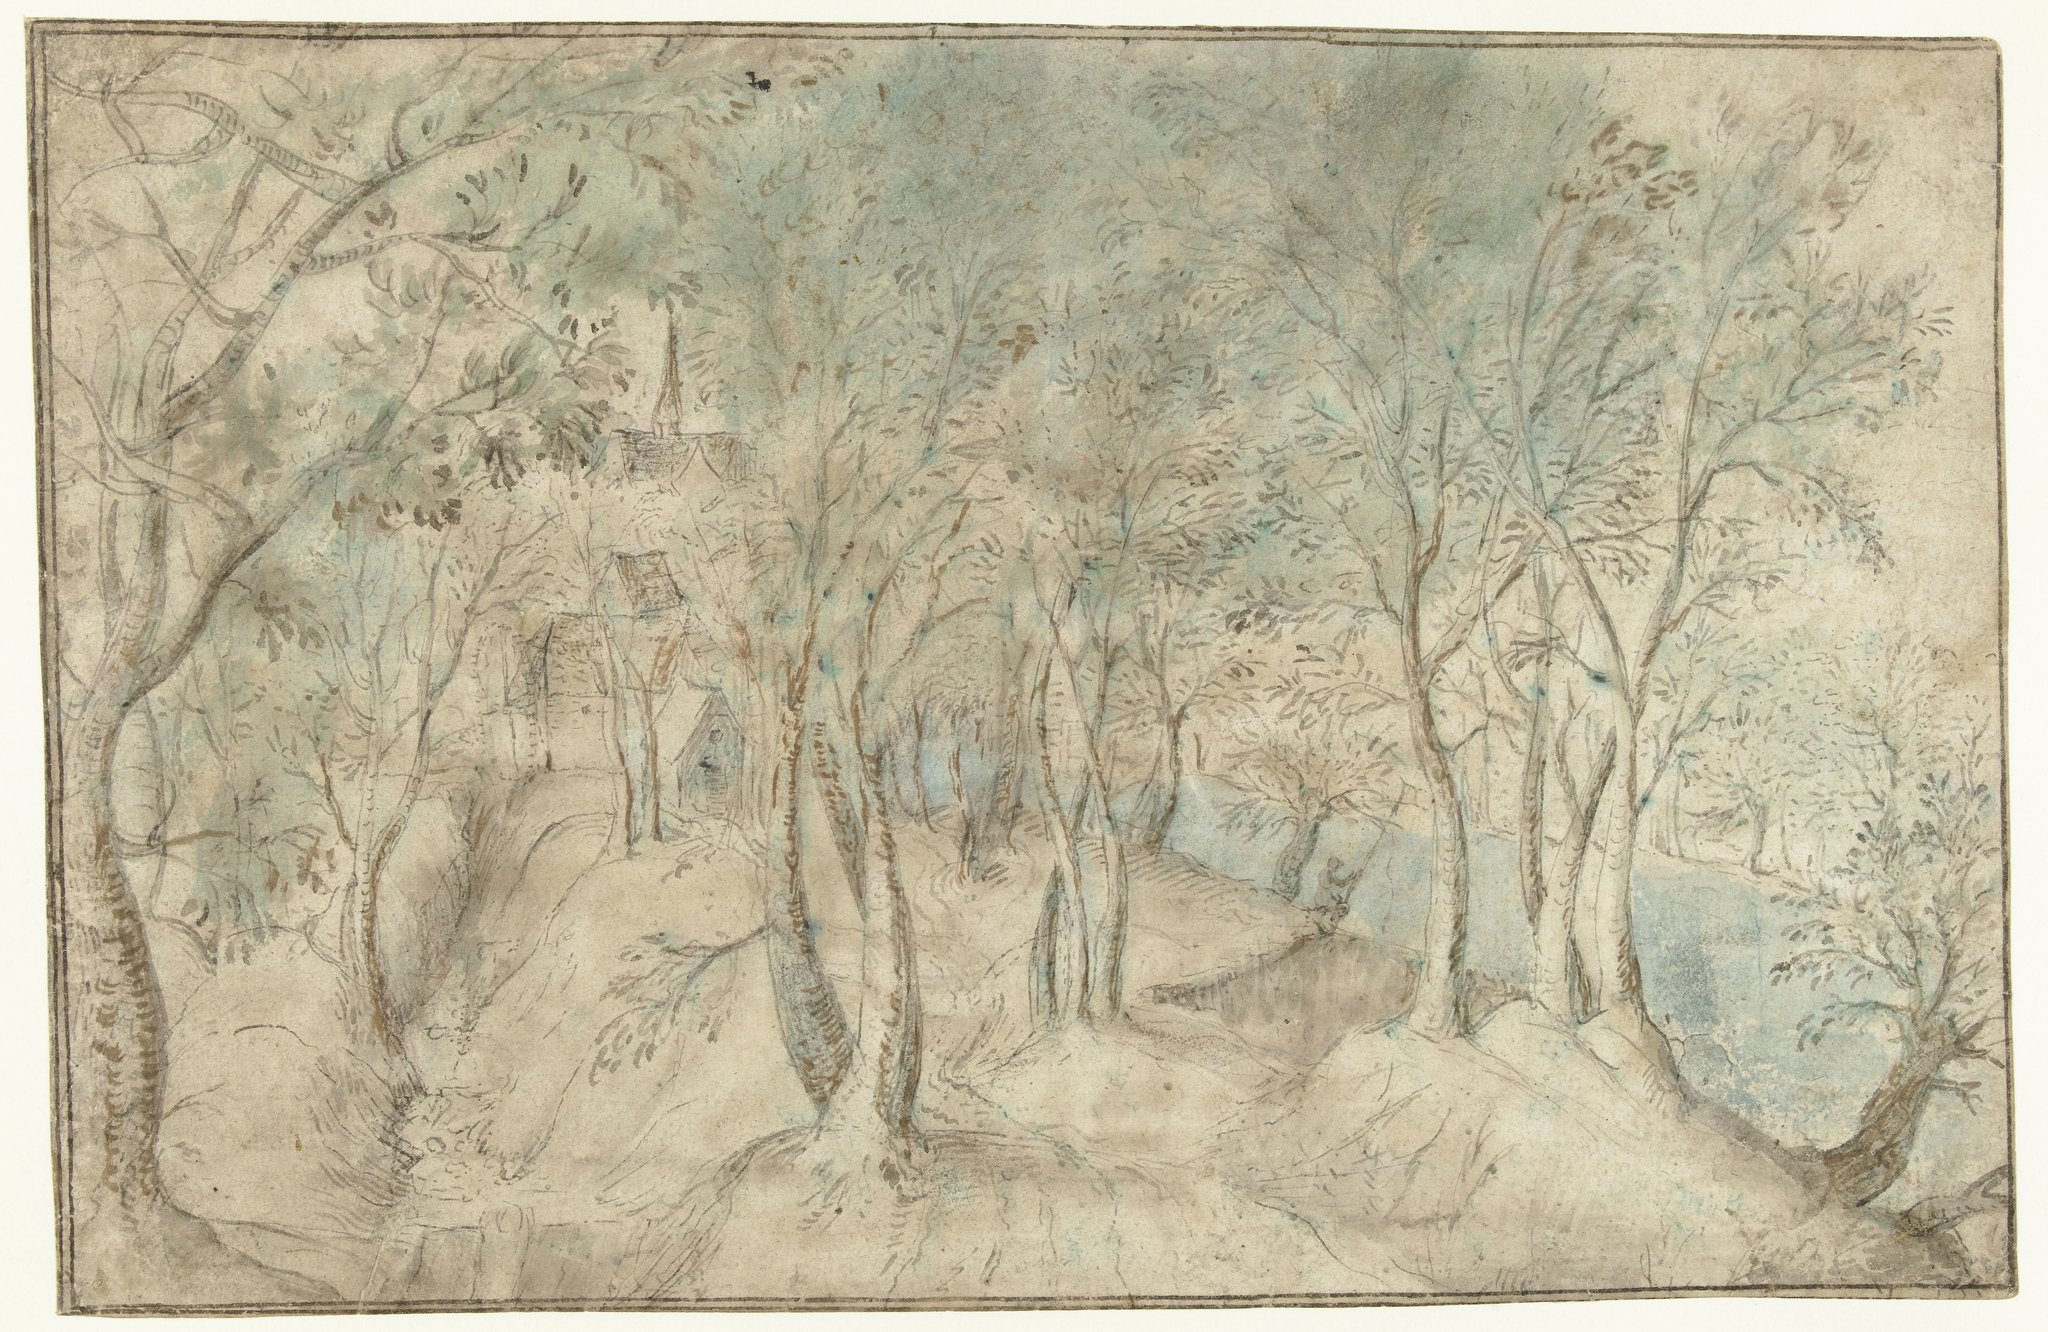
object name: drawing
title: Gezicht op een dorp bij een rivier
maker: hendrick gijsmans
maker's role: draughtsman, painter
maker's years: 1552-1612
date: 1570-1591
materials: paper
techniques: brush, pen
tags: forest, wood, outskirts of village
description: Een tekening in het Louvre verbonden met Coninxloo laat bijna dezelfde compositie zien, afgezien van een aantal kleine verschillen. Waarschijnlijk zijn beide vellen afgeleidt van een origineel door Coninxloo. Ik begrijp Wegner's mening niet, die in 1976 vol hield dat onze tekening het origineel was. Een andere tekening van Gijsmans is in het Prentenkabinet te Leiden is in 1973 door W.Wegner gepubliceert. Deze laatste laat geen relatie met Coninxloo zien maar met Gijsmans' leraar, Gillis Mostaert.